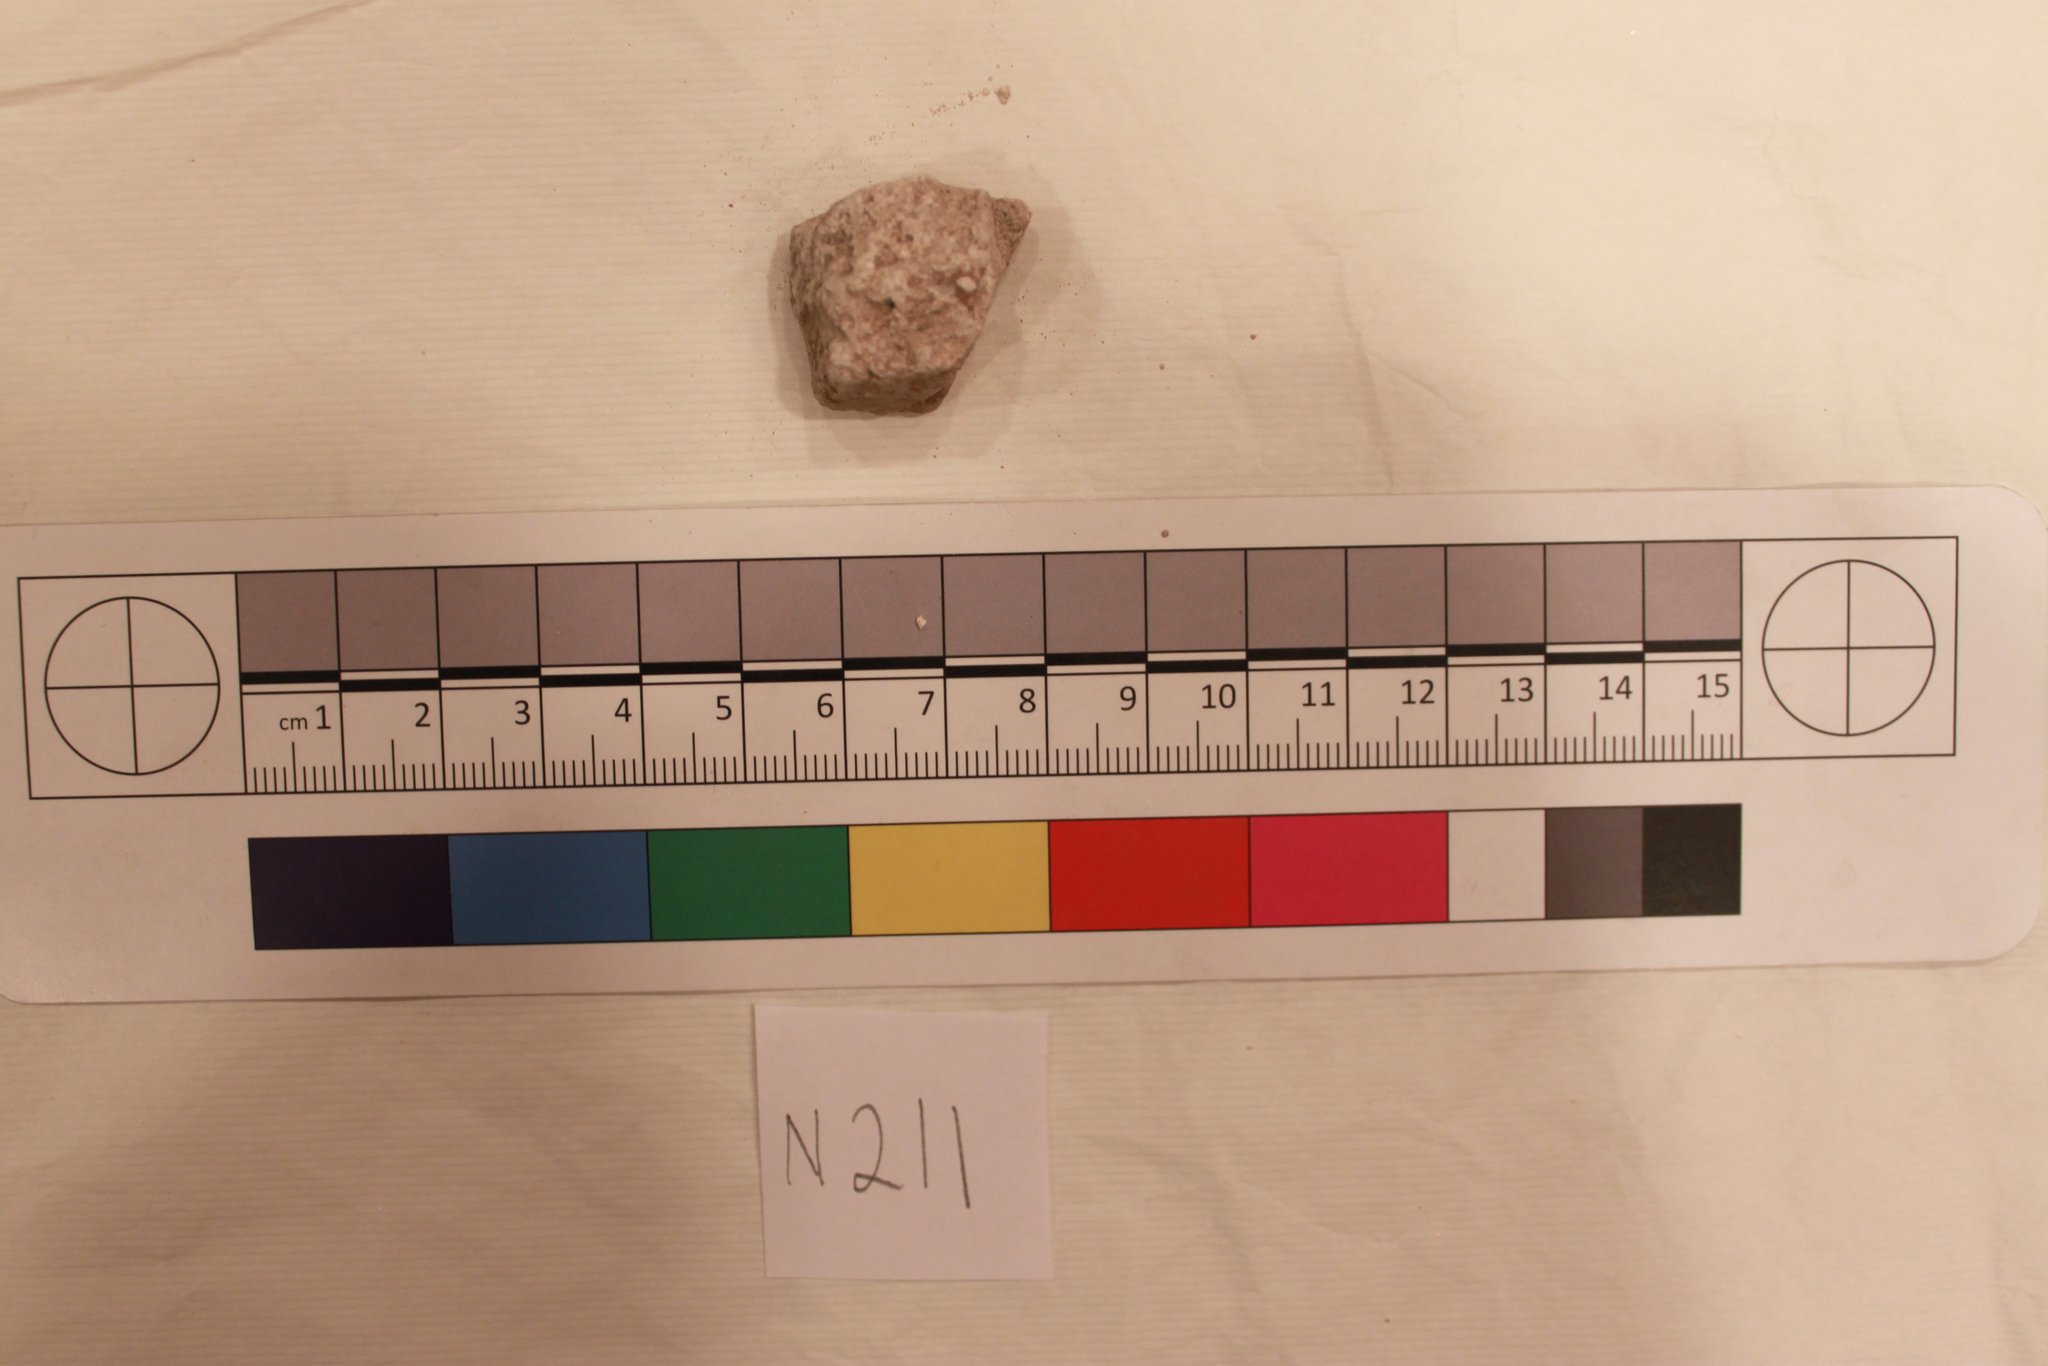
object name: fragment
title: Stucco Fragment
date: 701-1200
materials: plaster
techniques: carving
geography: iran